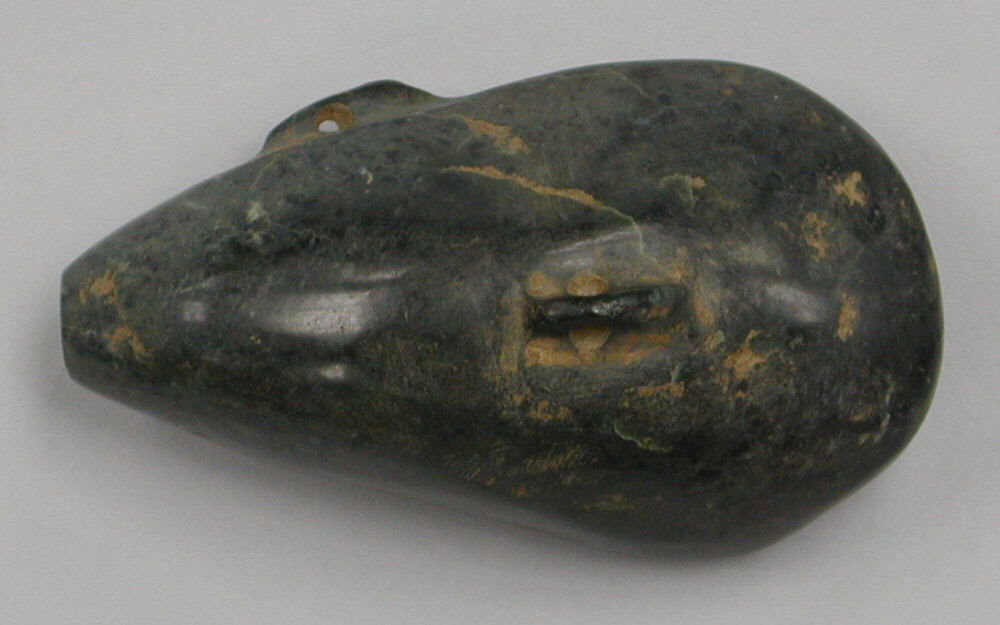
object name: vessel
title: Miniature Vessel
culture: mezcala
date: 1-800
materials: stone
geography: mexico